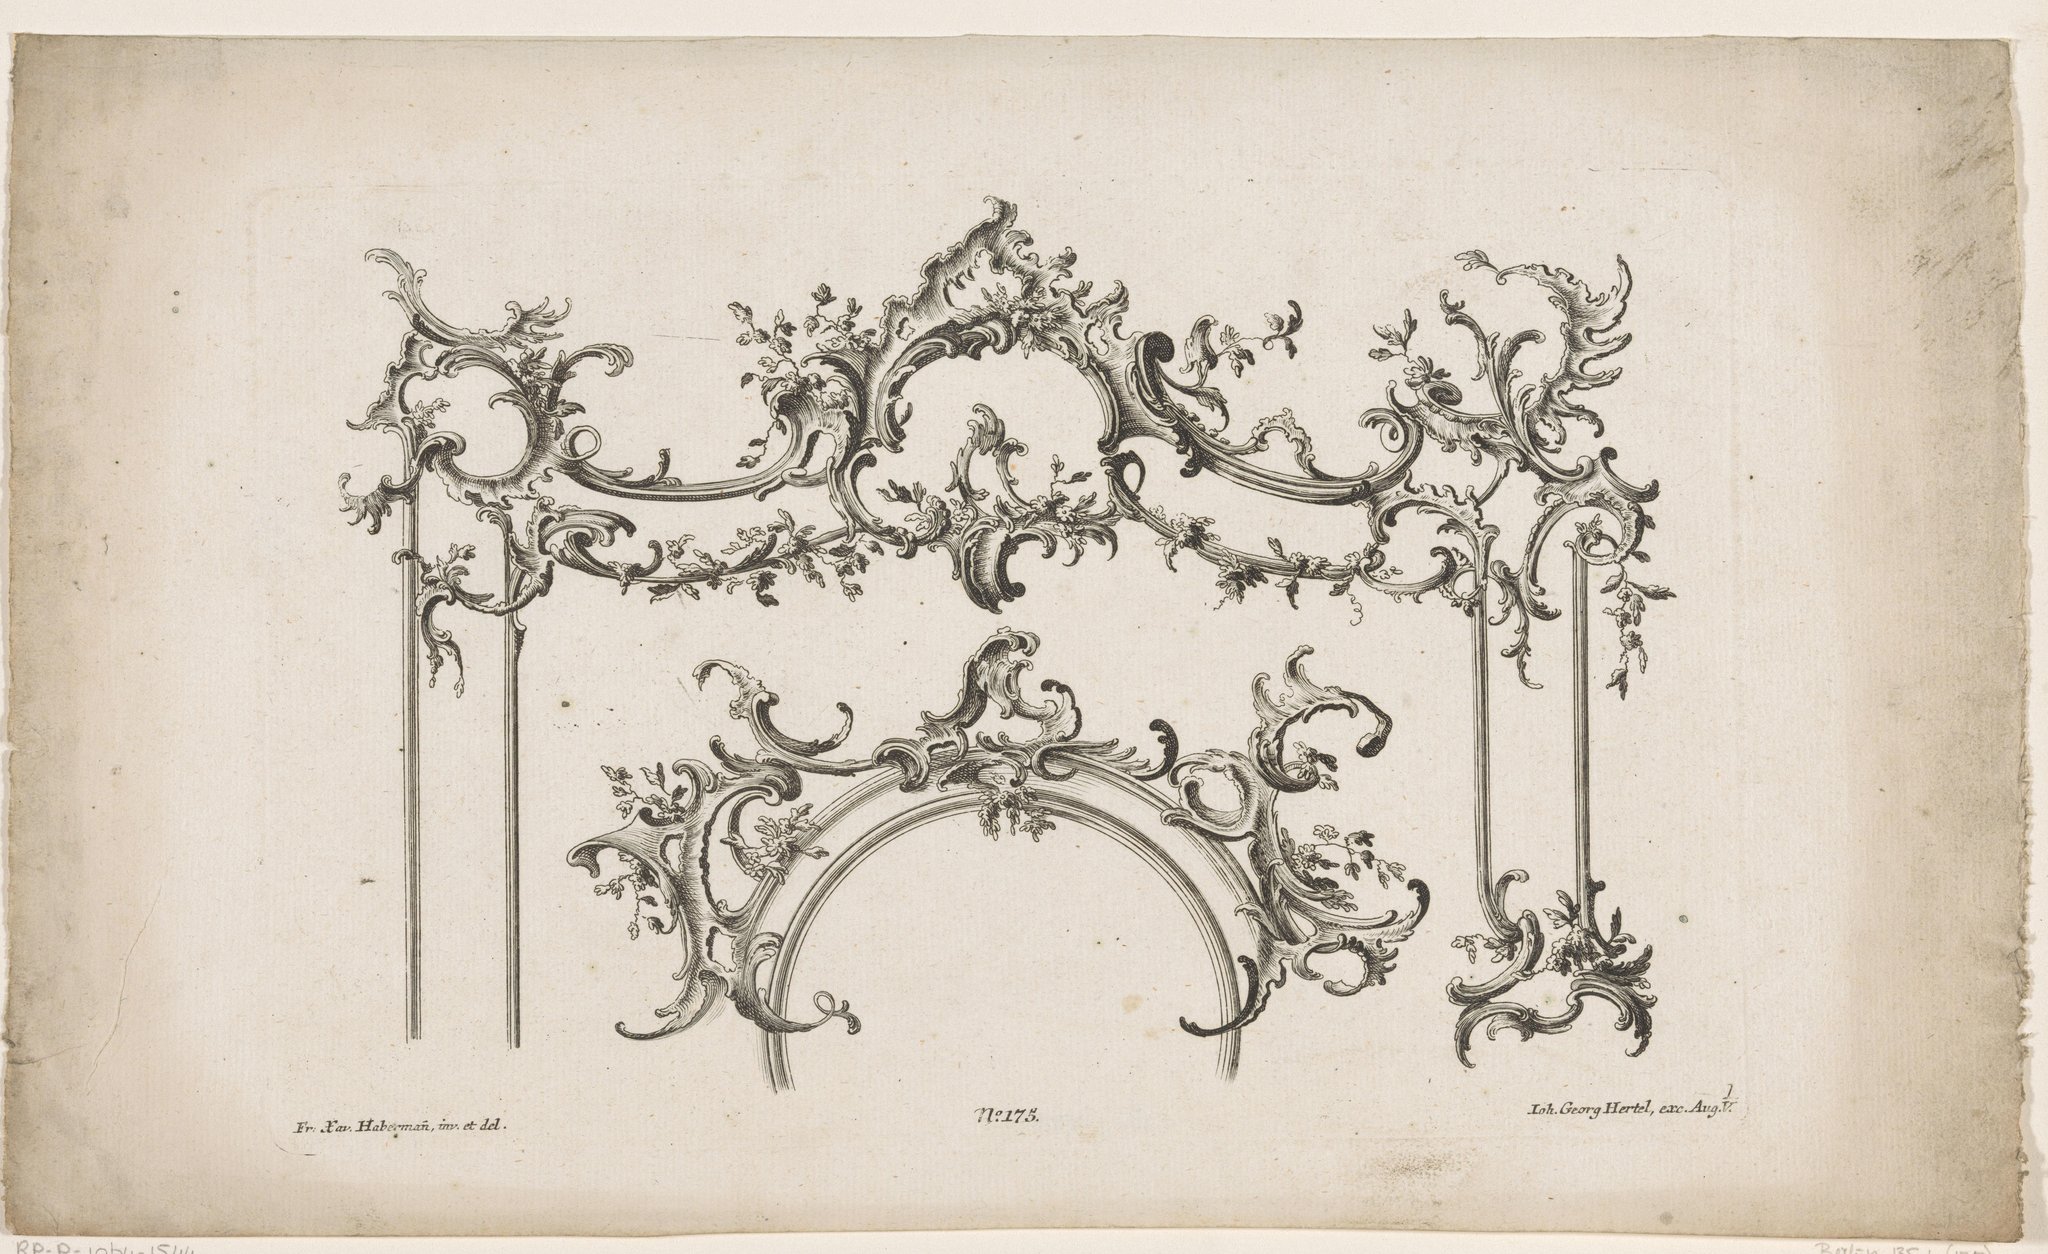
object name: ornament print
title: Omlijstingen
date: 1731-1775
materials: paper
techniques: etching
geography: augsburg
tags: rocaille ornament, ornaments ~ art (+ framing decorations)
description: Twee rocaille omlijstingen met bladmotieven. Uitgeversnummer 175.